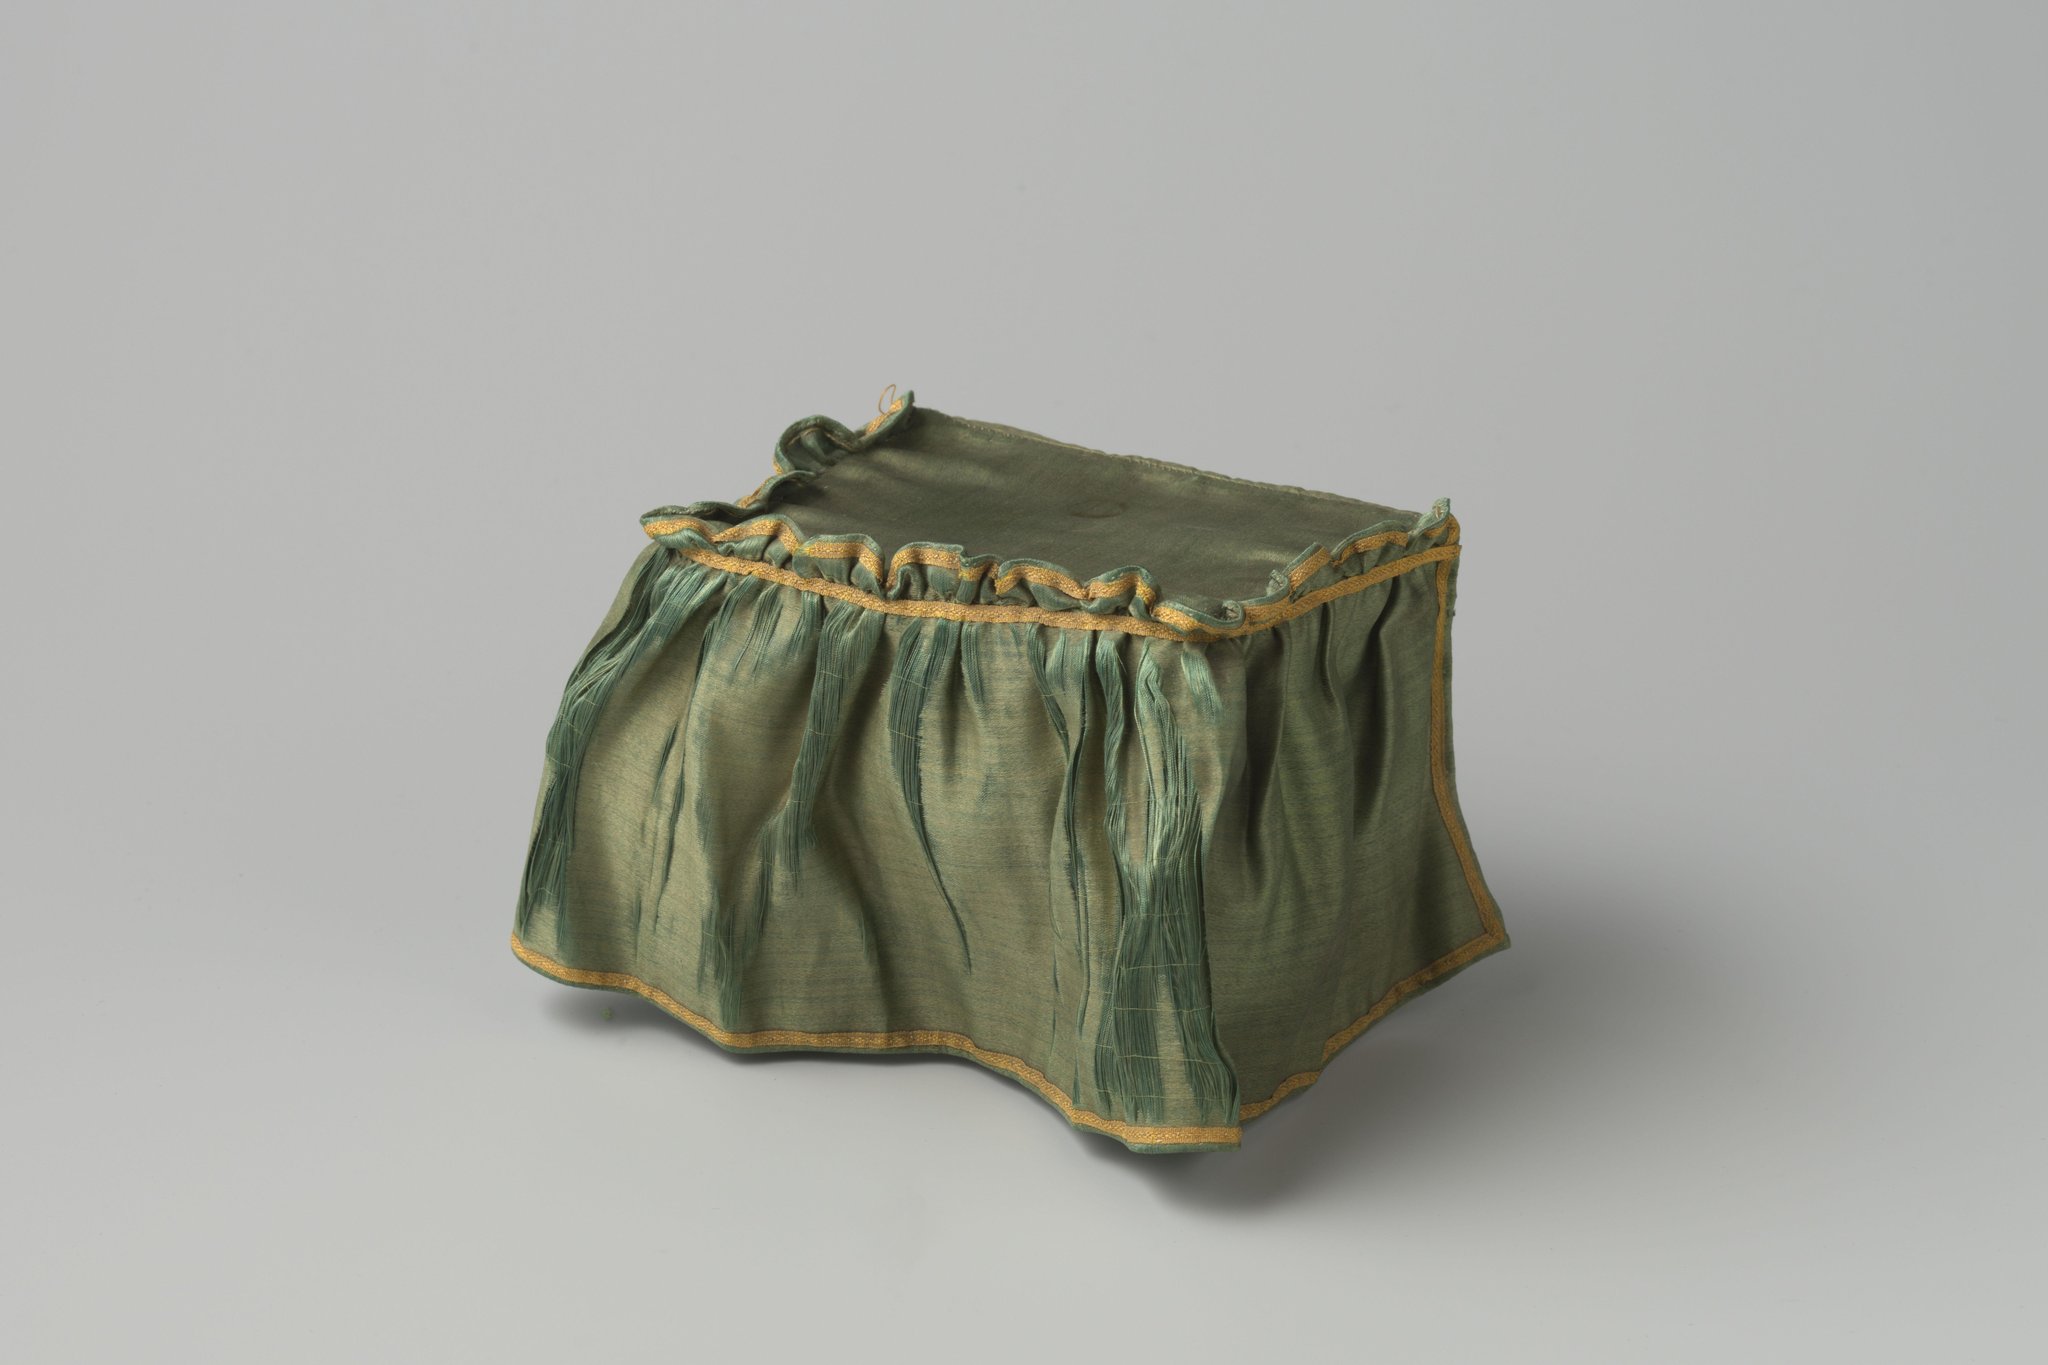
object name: miniature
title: Tafelkleed vervaardigd van groen zijden satijn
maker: Anonymous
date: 1690-1710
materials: silk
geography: amsterdam